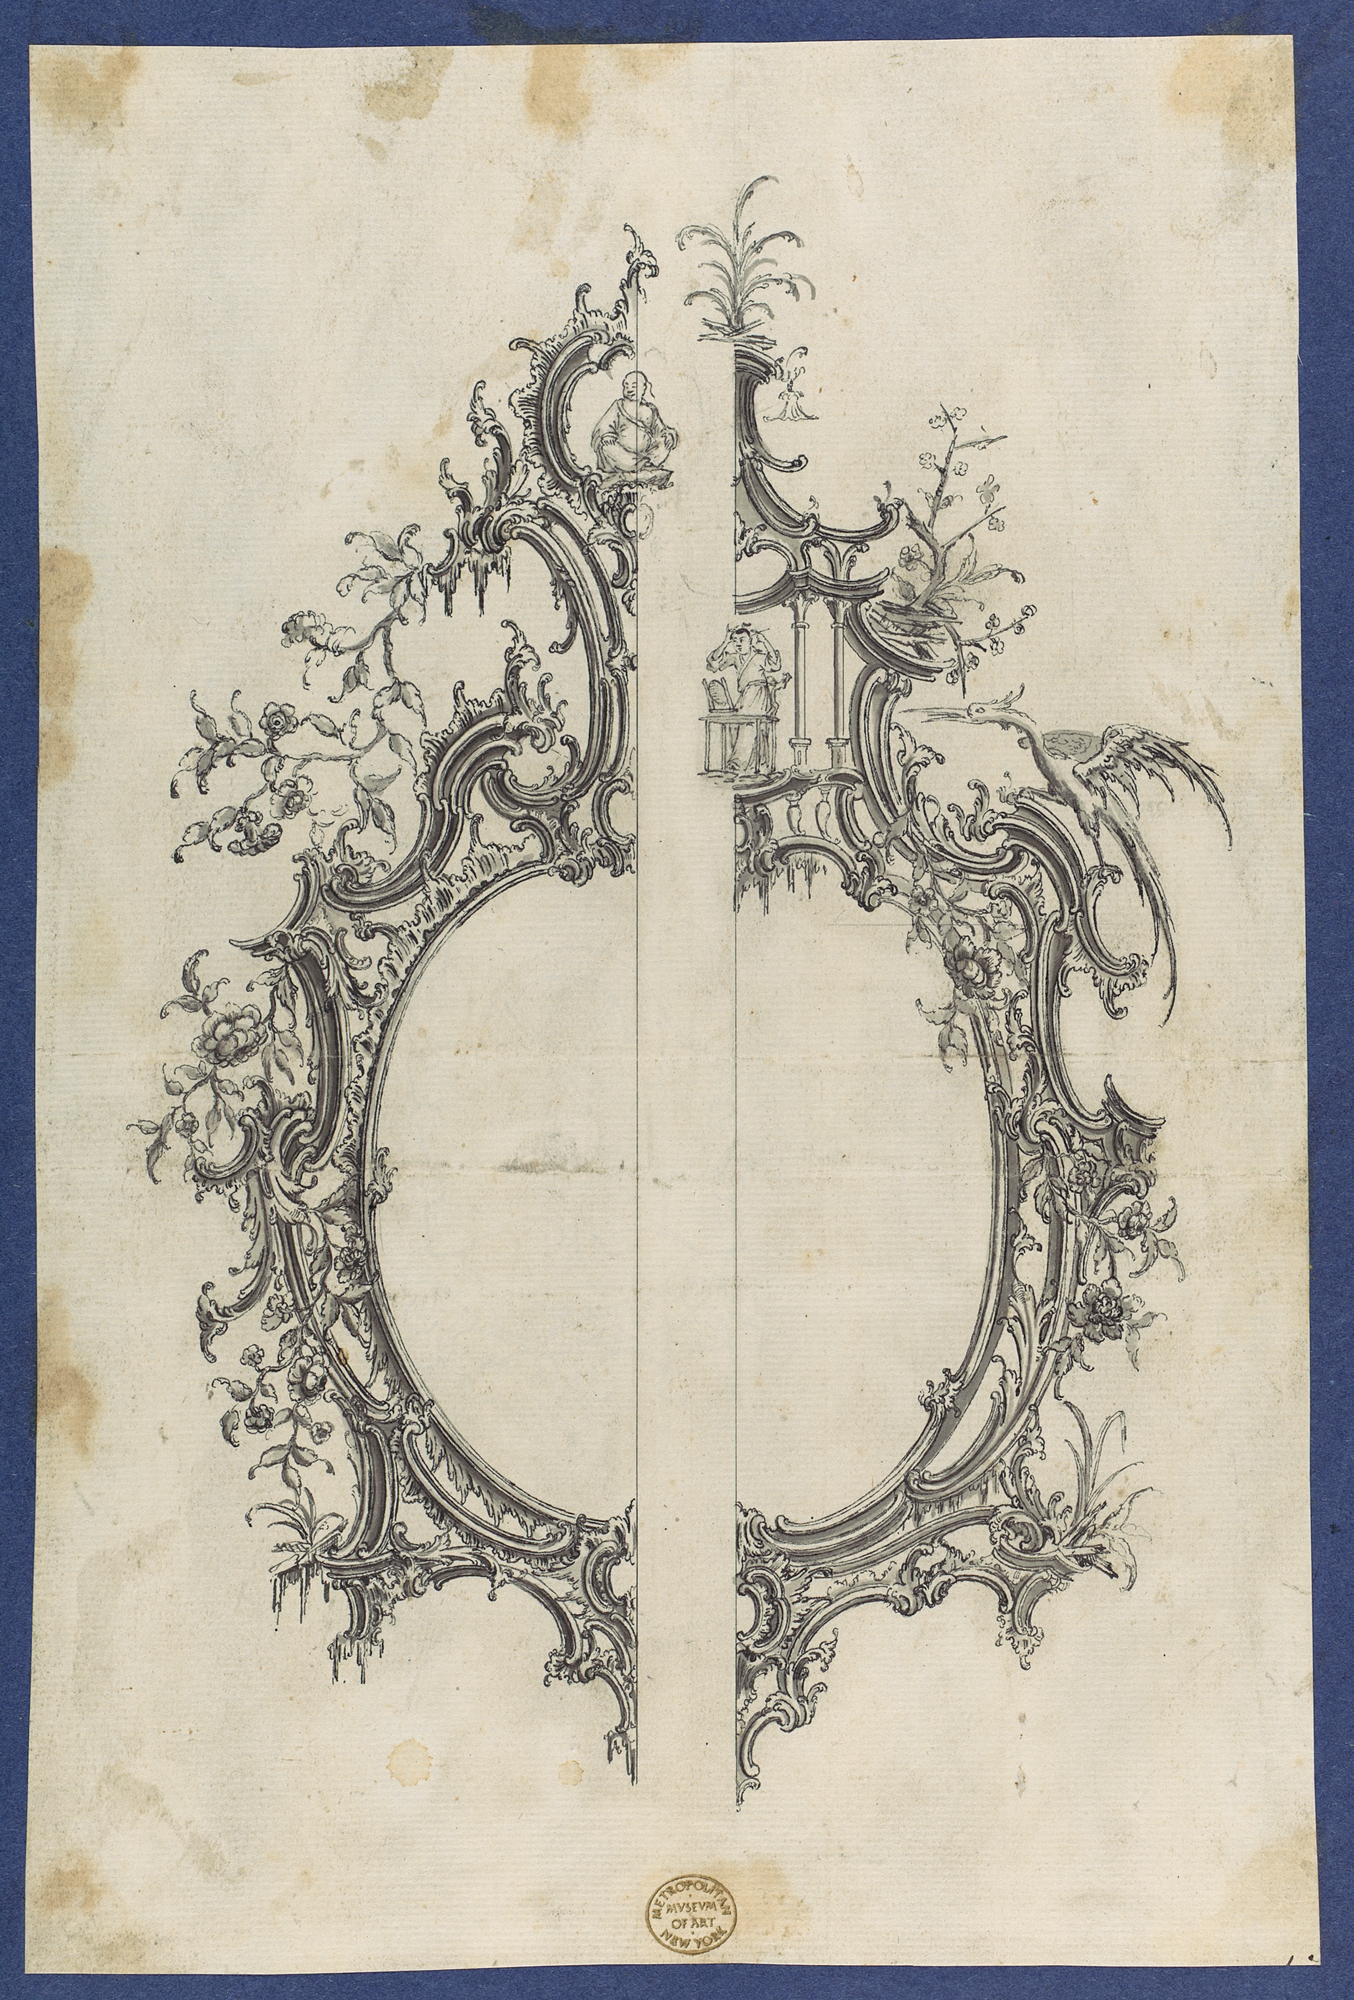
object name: ornament architecture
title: Pier Glass Frames, in Chippendale Drawings, Vol. I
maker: thomas chippendale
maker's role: artist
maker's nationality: british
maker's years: 1718-1779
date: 1754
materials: ink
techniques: wash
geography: london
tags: ornament